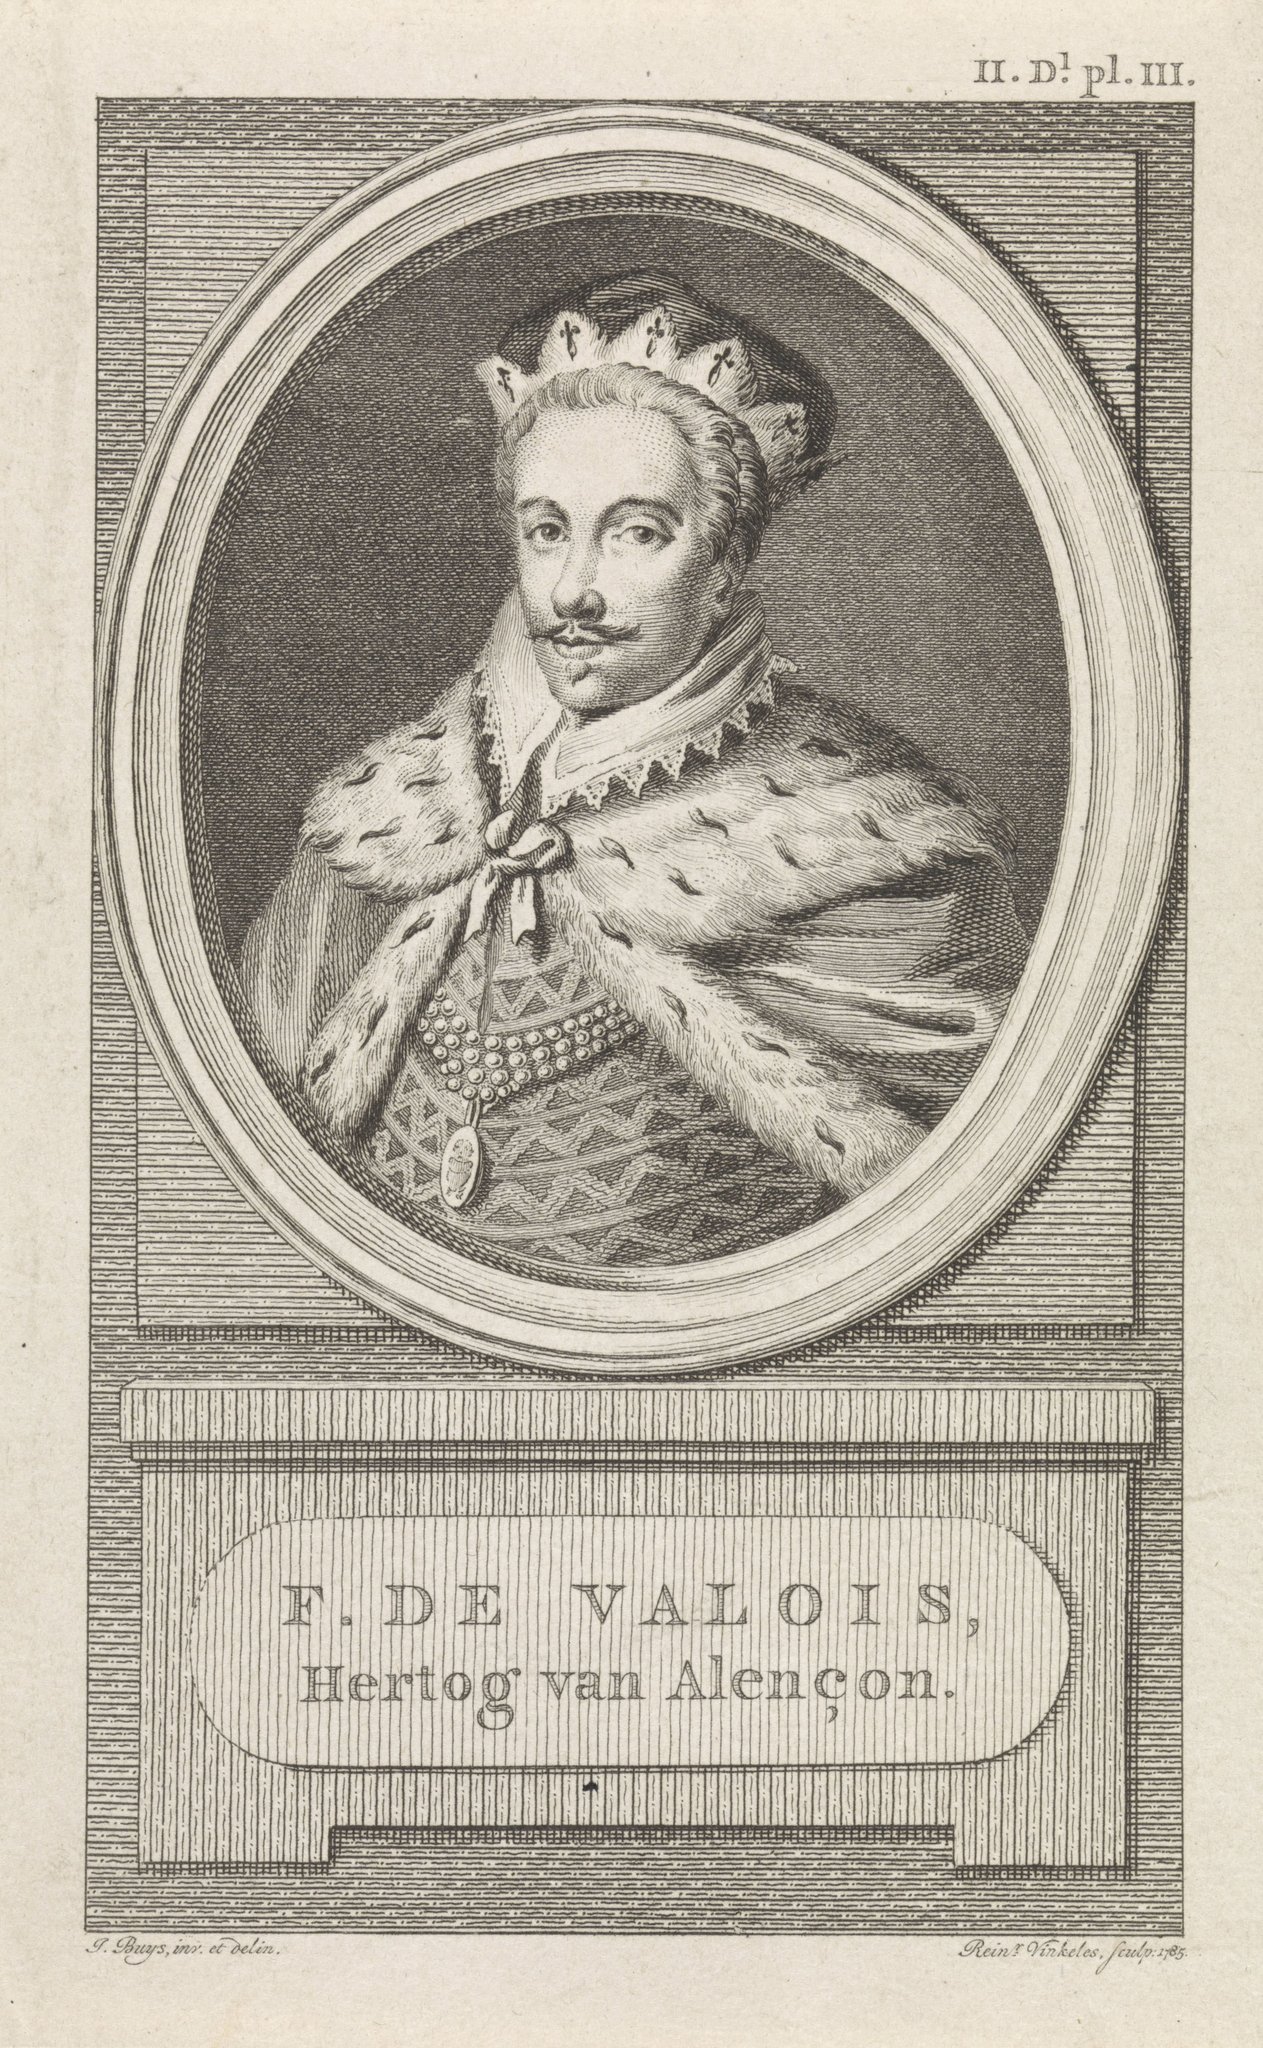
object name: book illustration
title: Portret van François-Hercule de Valois hertog van Anjou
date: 1785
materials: paper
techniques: engraving, etching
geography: amsterdam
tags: paris, françois-hercule de valois (hertog van anjou)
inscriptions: collector's mark: Lugt 2228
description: Prent gebruikt als boekillustratie in: Kok, Jacobus. Vaderlandsch woordenboek : met kaarten, plaaten en pourtraitten. Amsterdam: Johannes Allart, 1785-1796. Deel II.